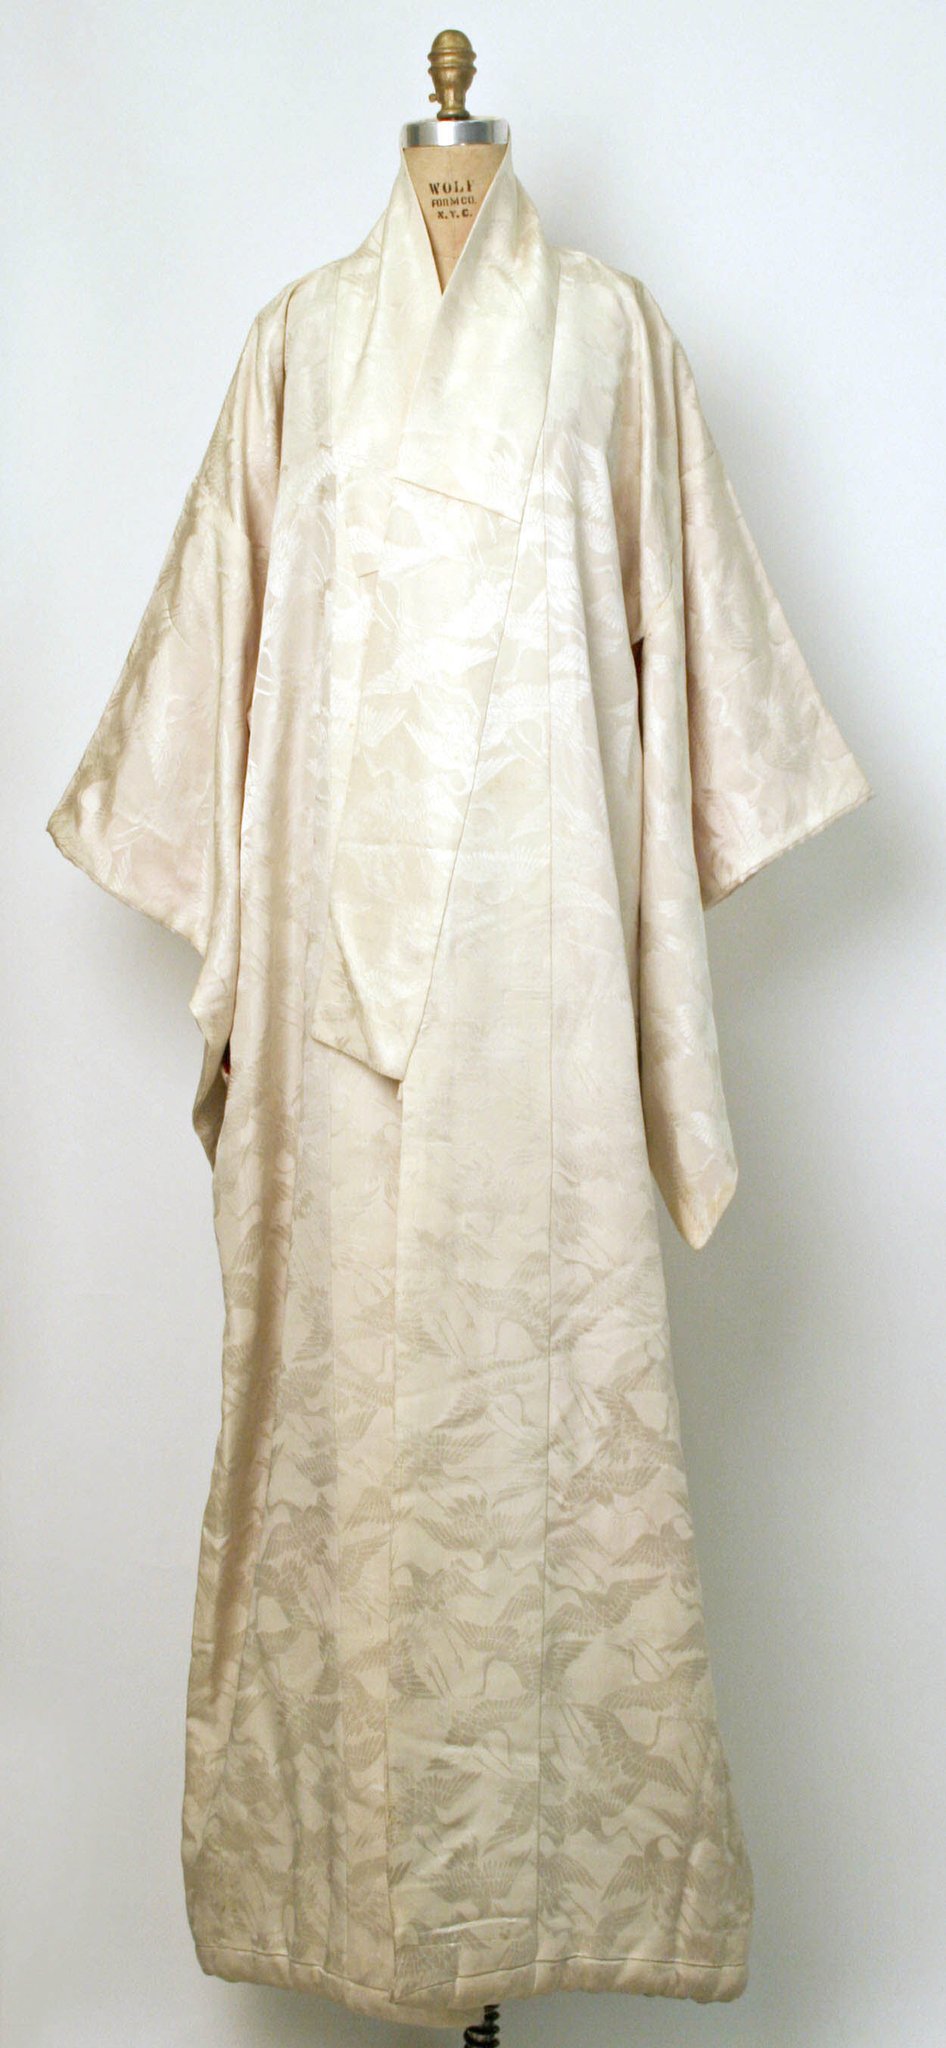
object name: kimono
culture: japanese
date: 1901-2000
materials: silk